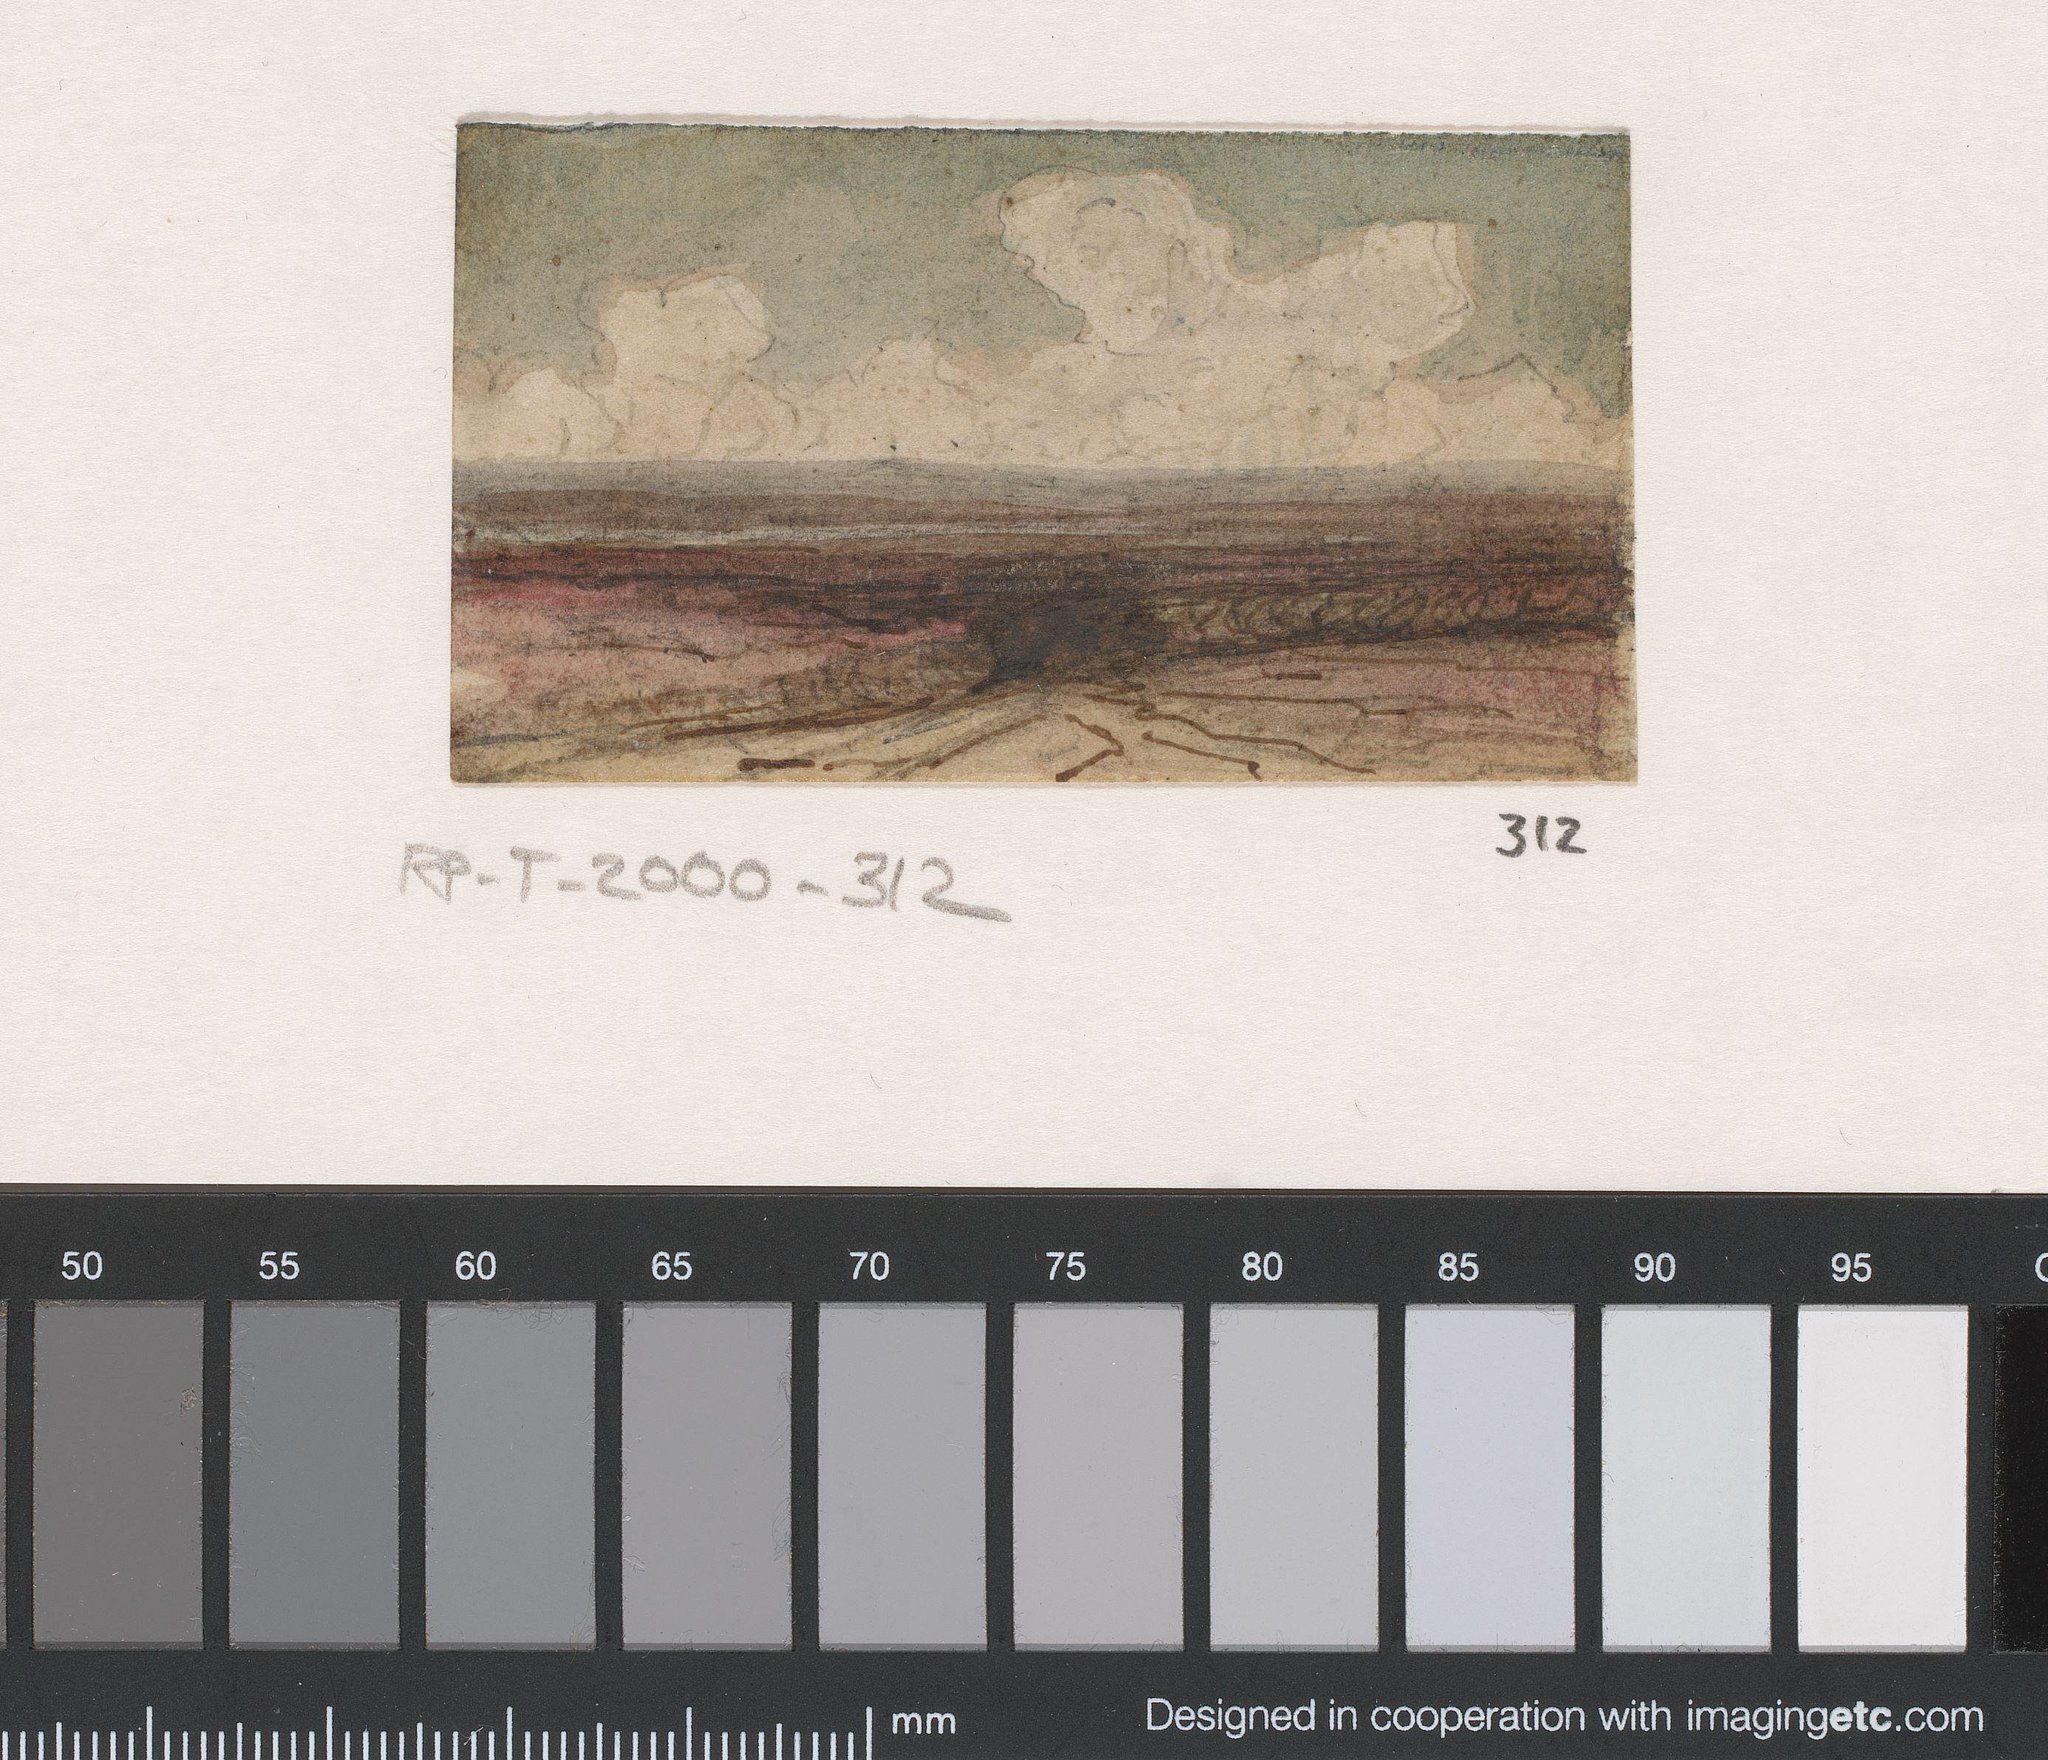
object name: drawing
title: Landschap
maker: johannes tavenraat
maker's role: draughtsman, painter, print maker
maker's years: 1809-1881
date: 1840-1880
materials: ink, paper, pencil, watercolor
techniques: brush, pen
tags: landscapes in the temperate zone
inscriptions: signature: ‘Tavenraat / fisoné’, collector's mark: Lugt 2228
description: Landschap. Op de achterkant een krabbel.